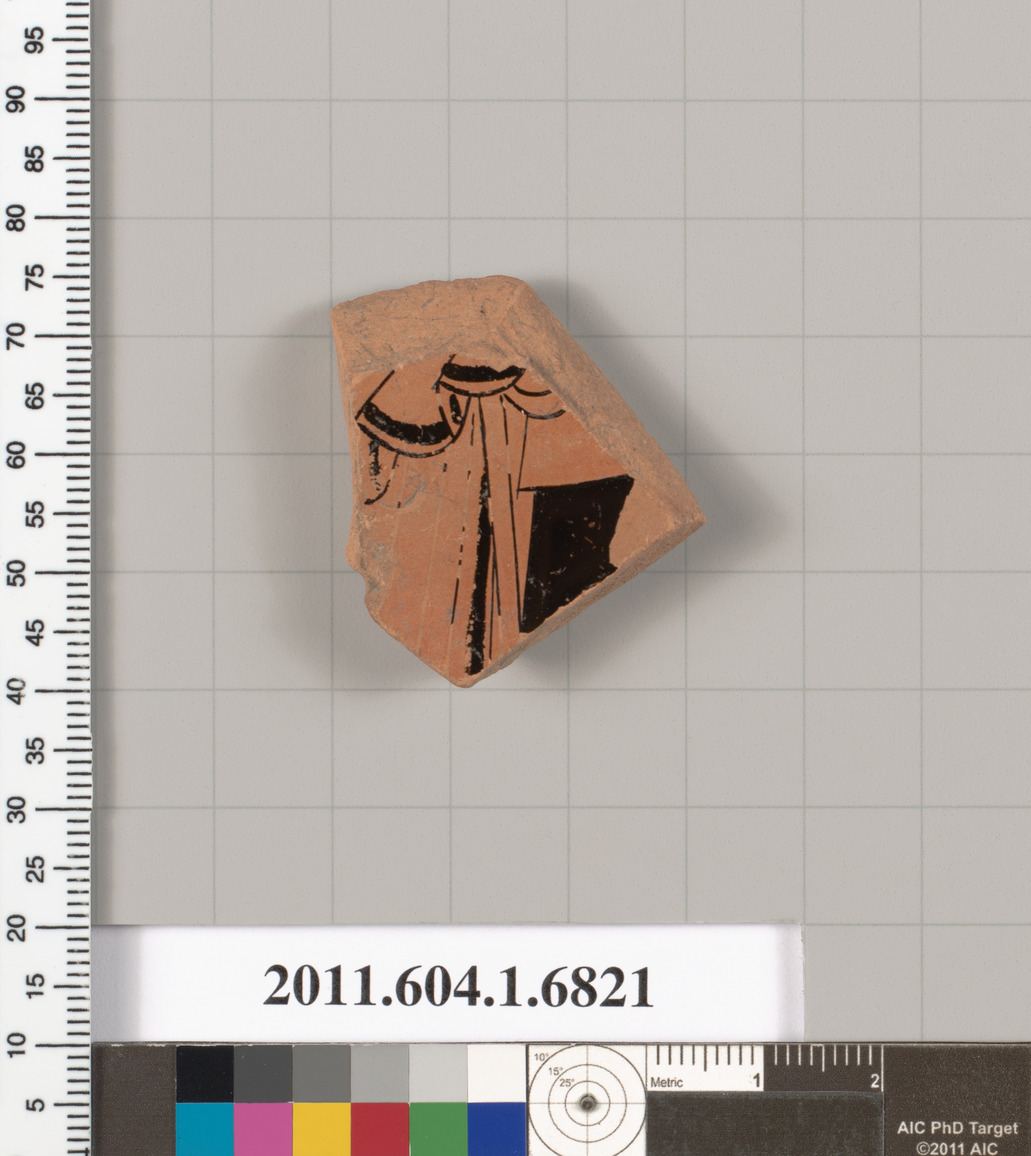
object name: kylix fragment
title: Terracotta fragment of a kylix (drinking cup)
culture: greek, attic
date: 490-470 BCE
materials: terracotta